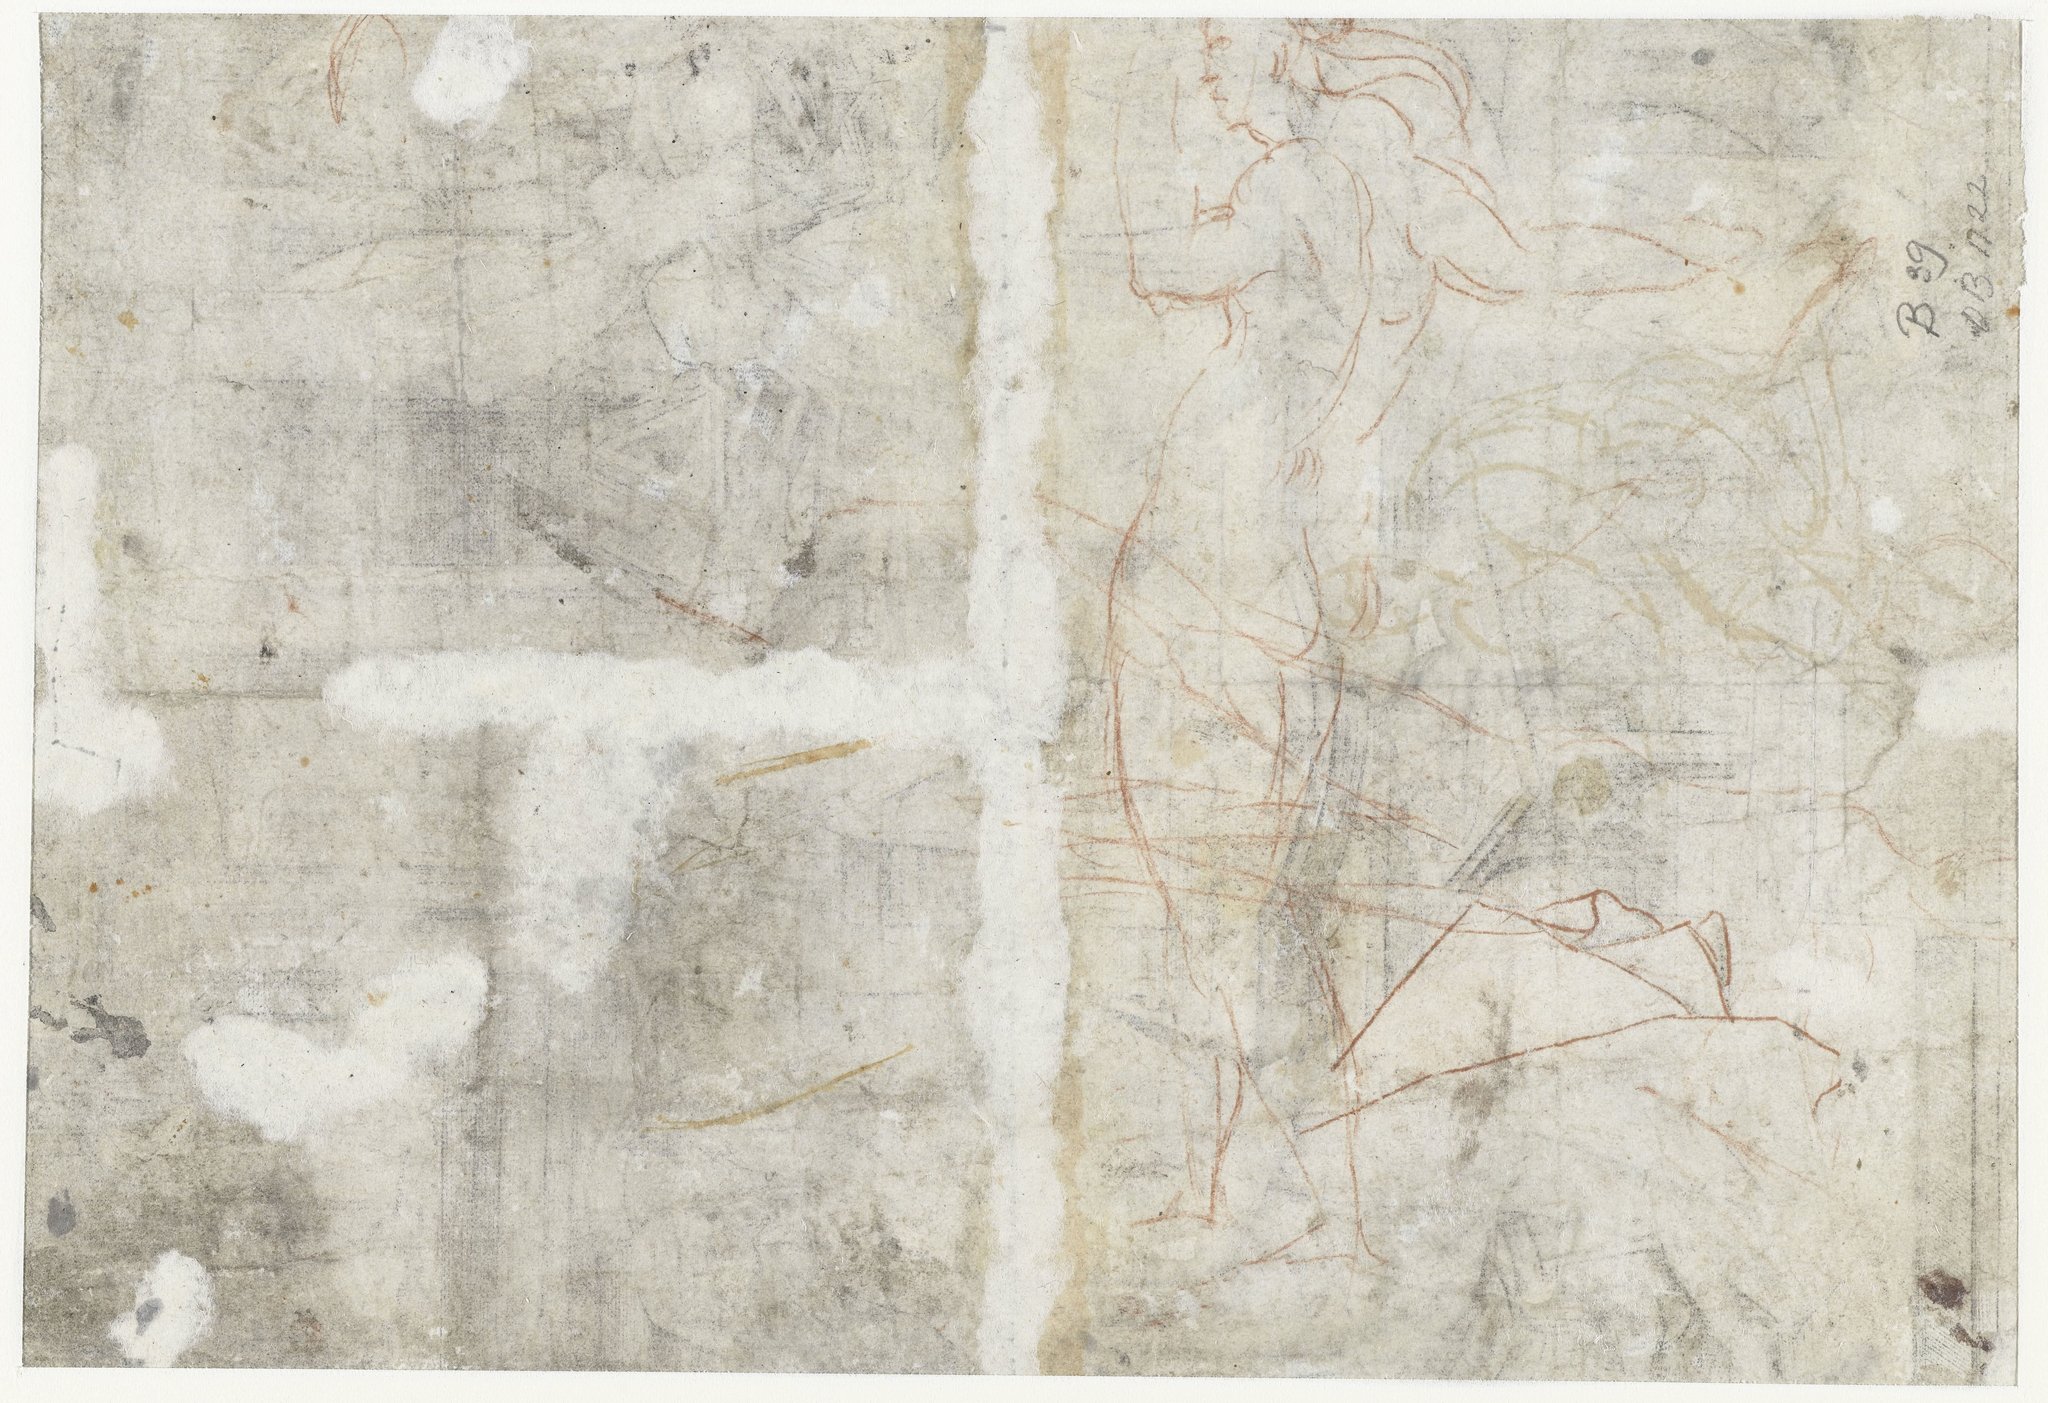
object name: drawing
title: Schets van een staande naakte figuur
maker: Anonymous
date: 1450-1500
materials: chalk, paper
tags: the (nude) human figure; 'corpo humano' (ripa)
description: Versozijde van een prent van Israhel van Meckenem uit een serie over het leven van Maria.